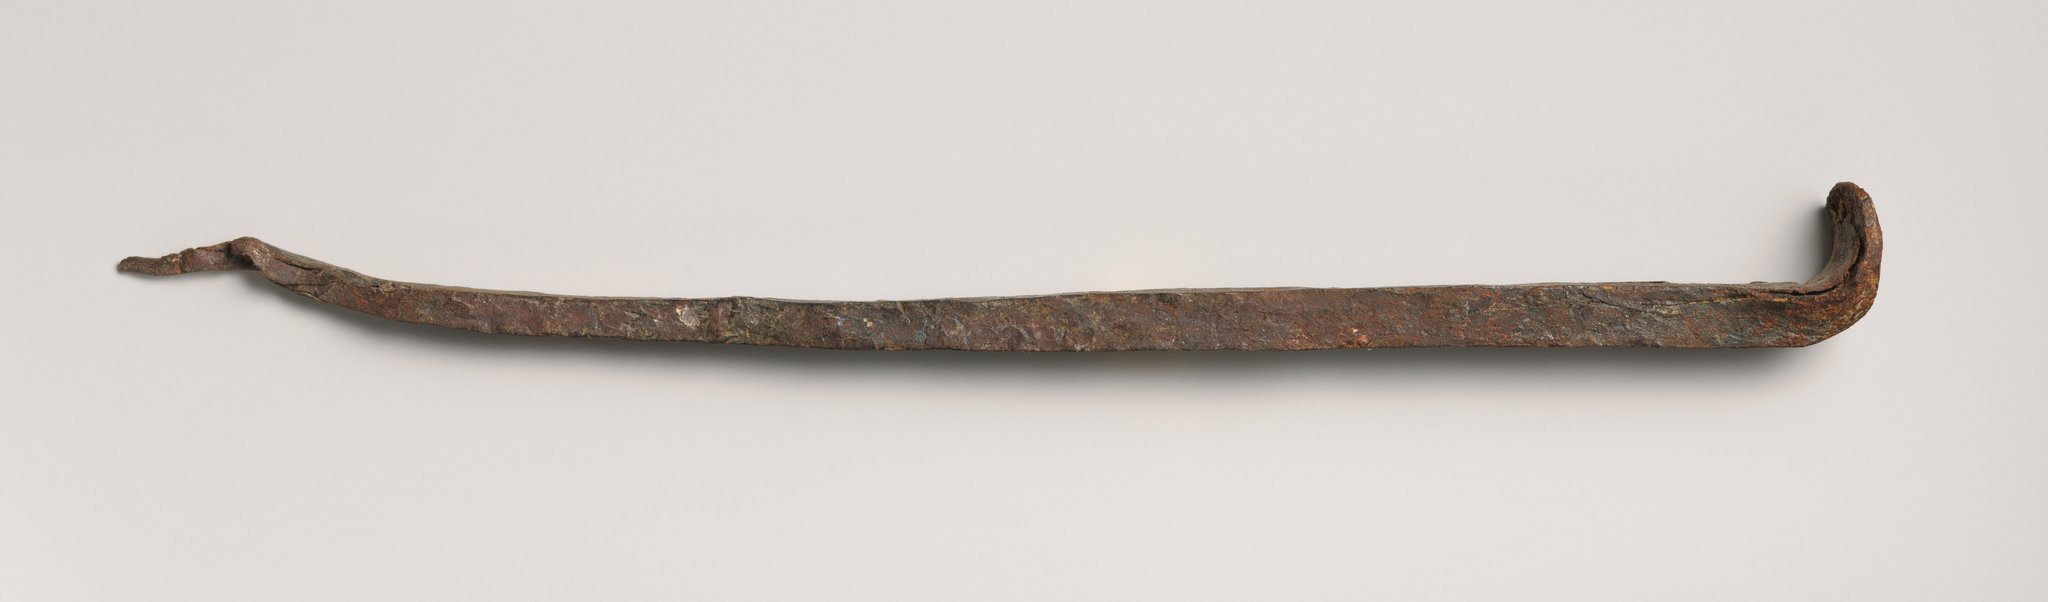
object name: key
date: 306-30 BCE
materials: iron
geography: egypt